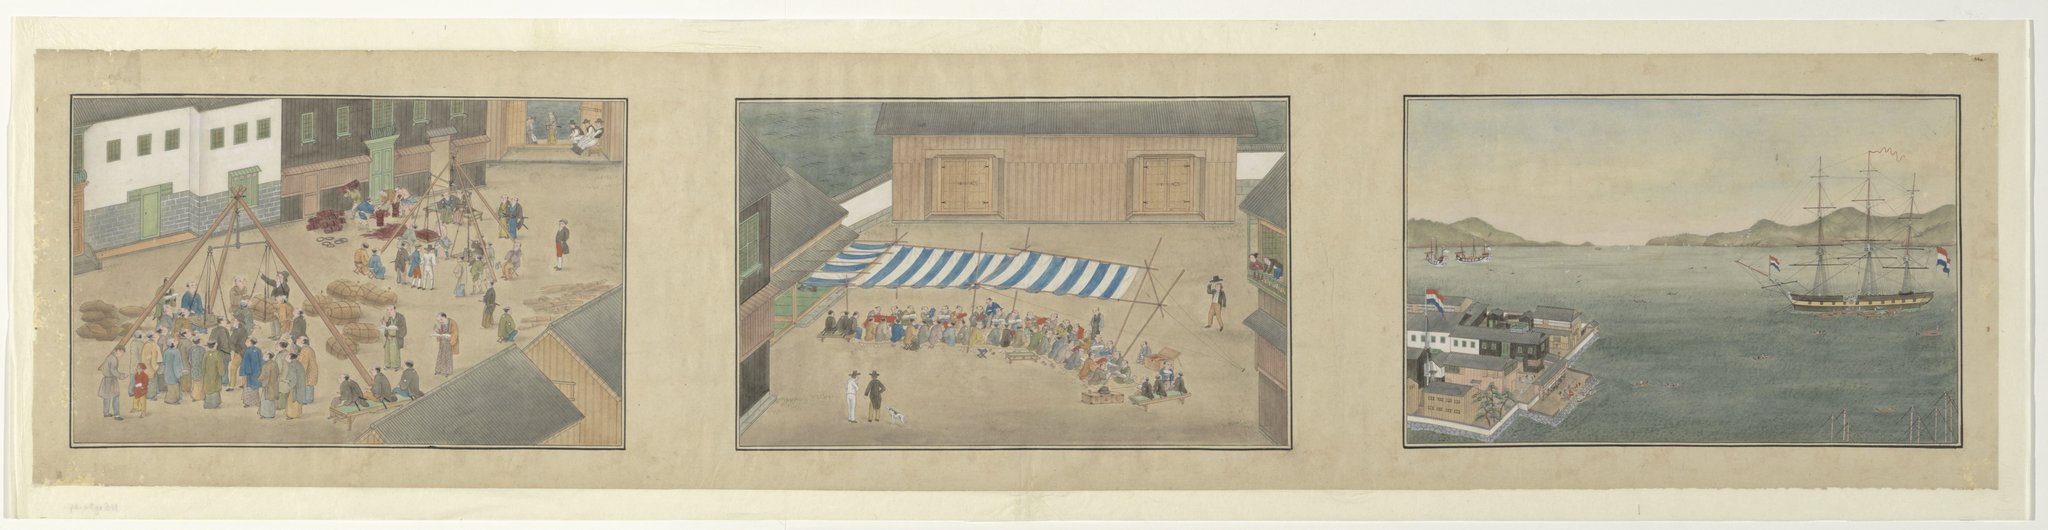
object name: emakimono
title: De Nederlandse handelsfactorij op Deshima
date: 1810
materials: ink, paper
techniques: brush in colors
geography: nagasaki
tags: verenigde oostindische compagnie, deshima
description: Drie scènes: Het wegen van handelswaar (mogelijk koper) bij twee grote weegschalen. Het verhandelen van laken onder een afdak van gestreepte stof. De baai van Nagasaki met links een deel van het eiland Deshima en rechts een Nederlands schip.